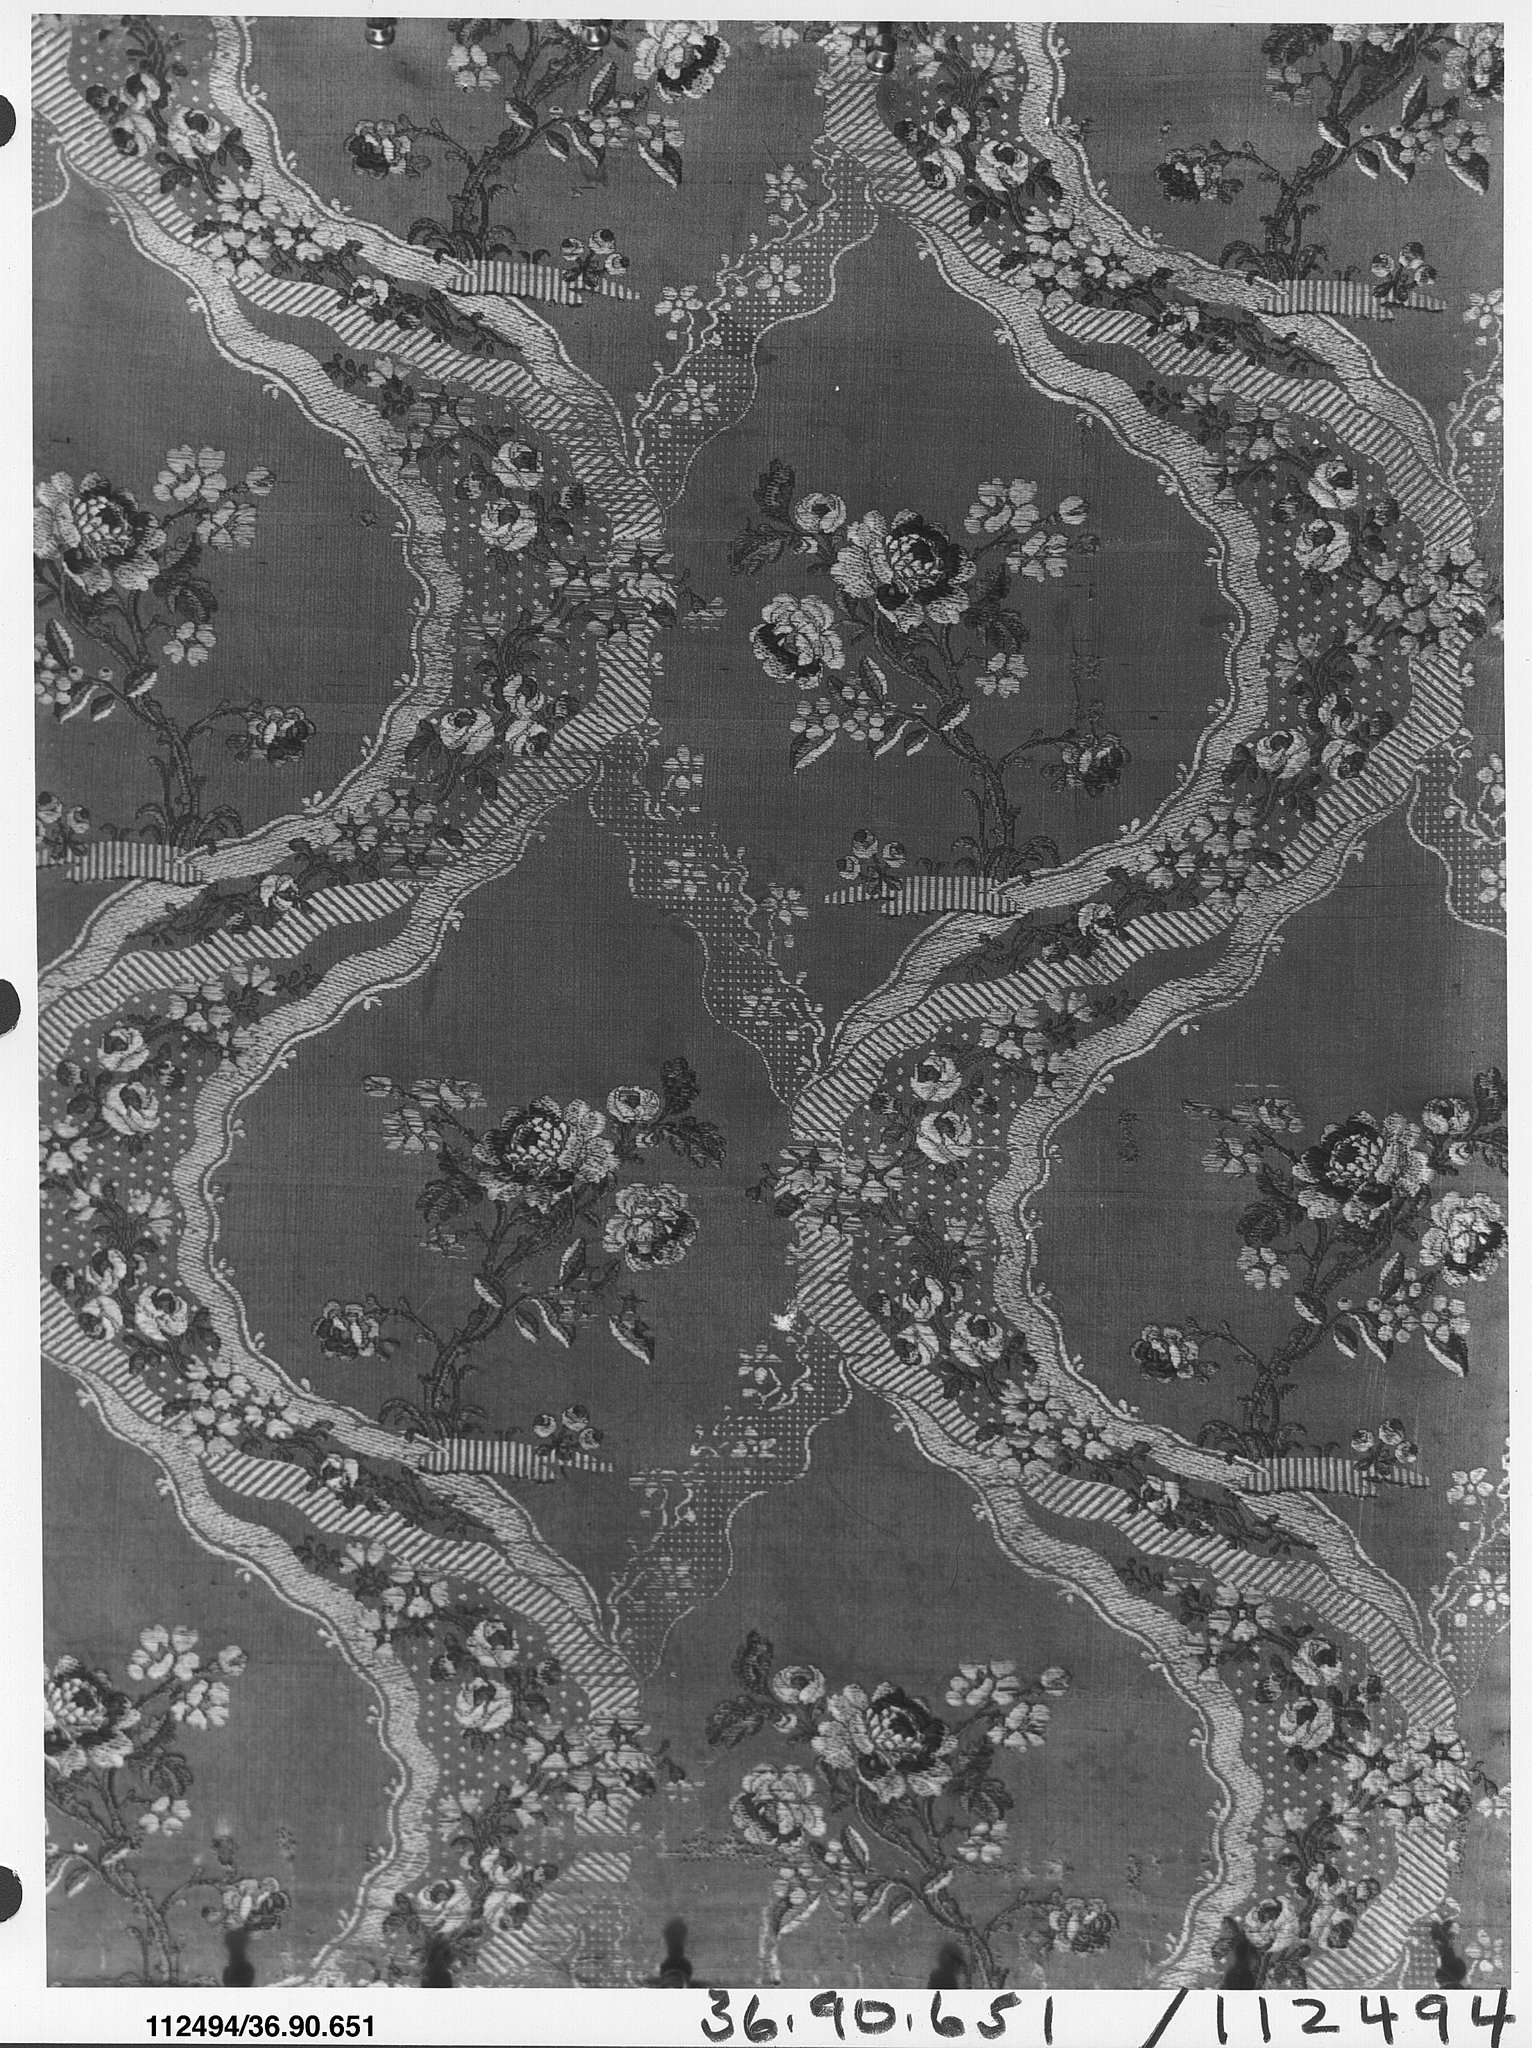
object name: piece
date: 1750-1760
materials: silk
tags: flowers,leaves